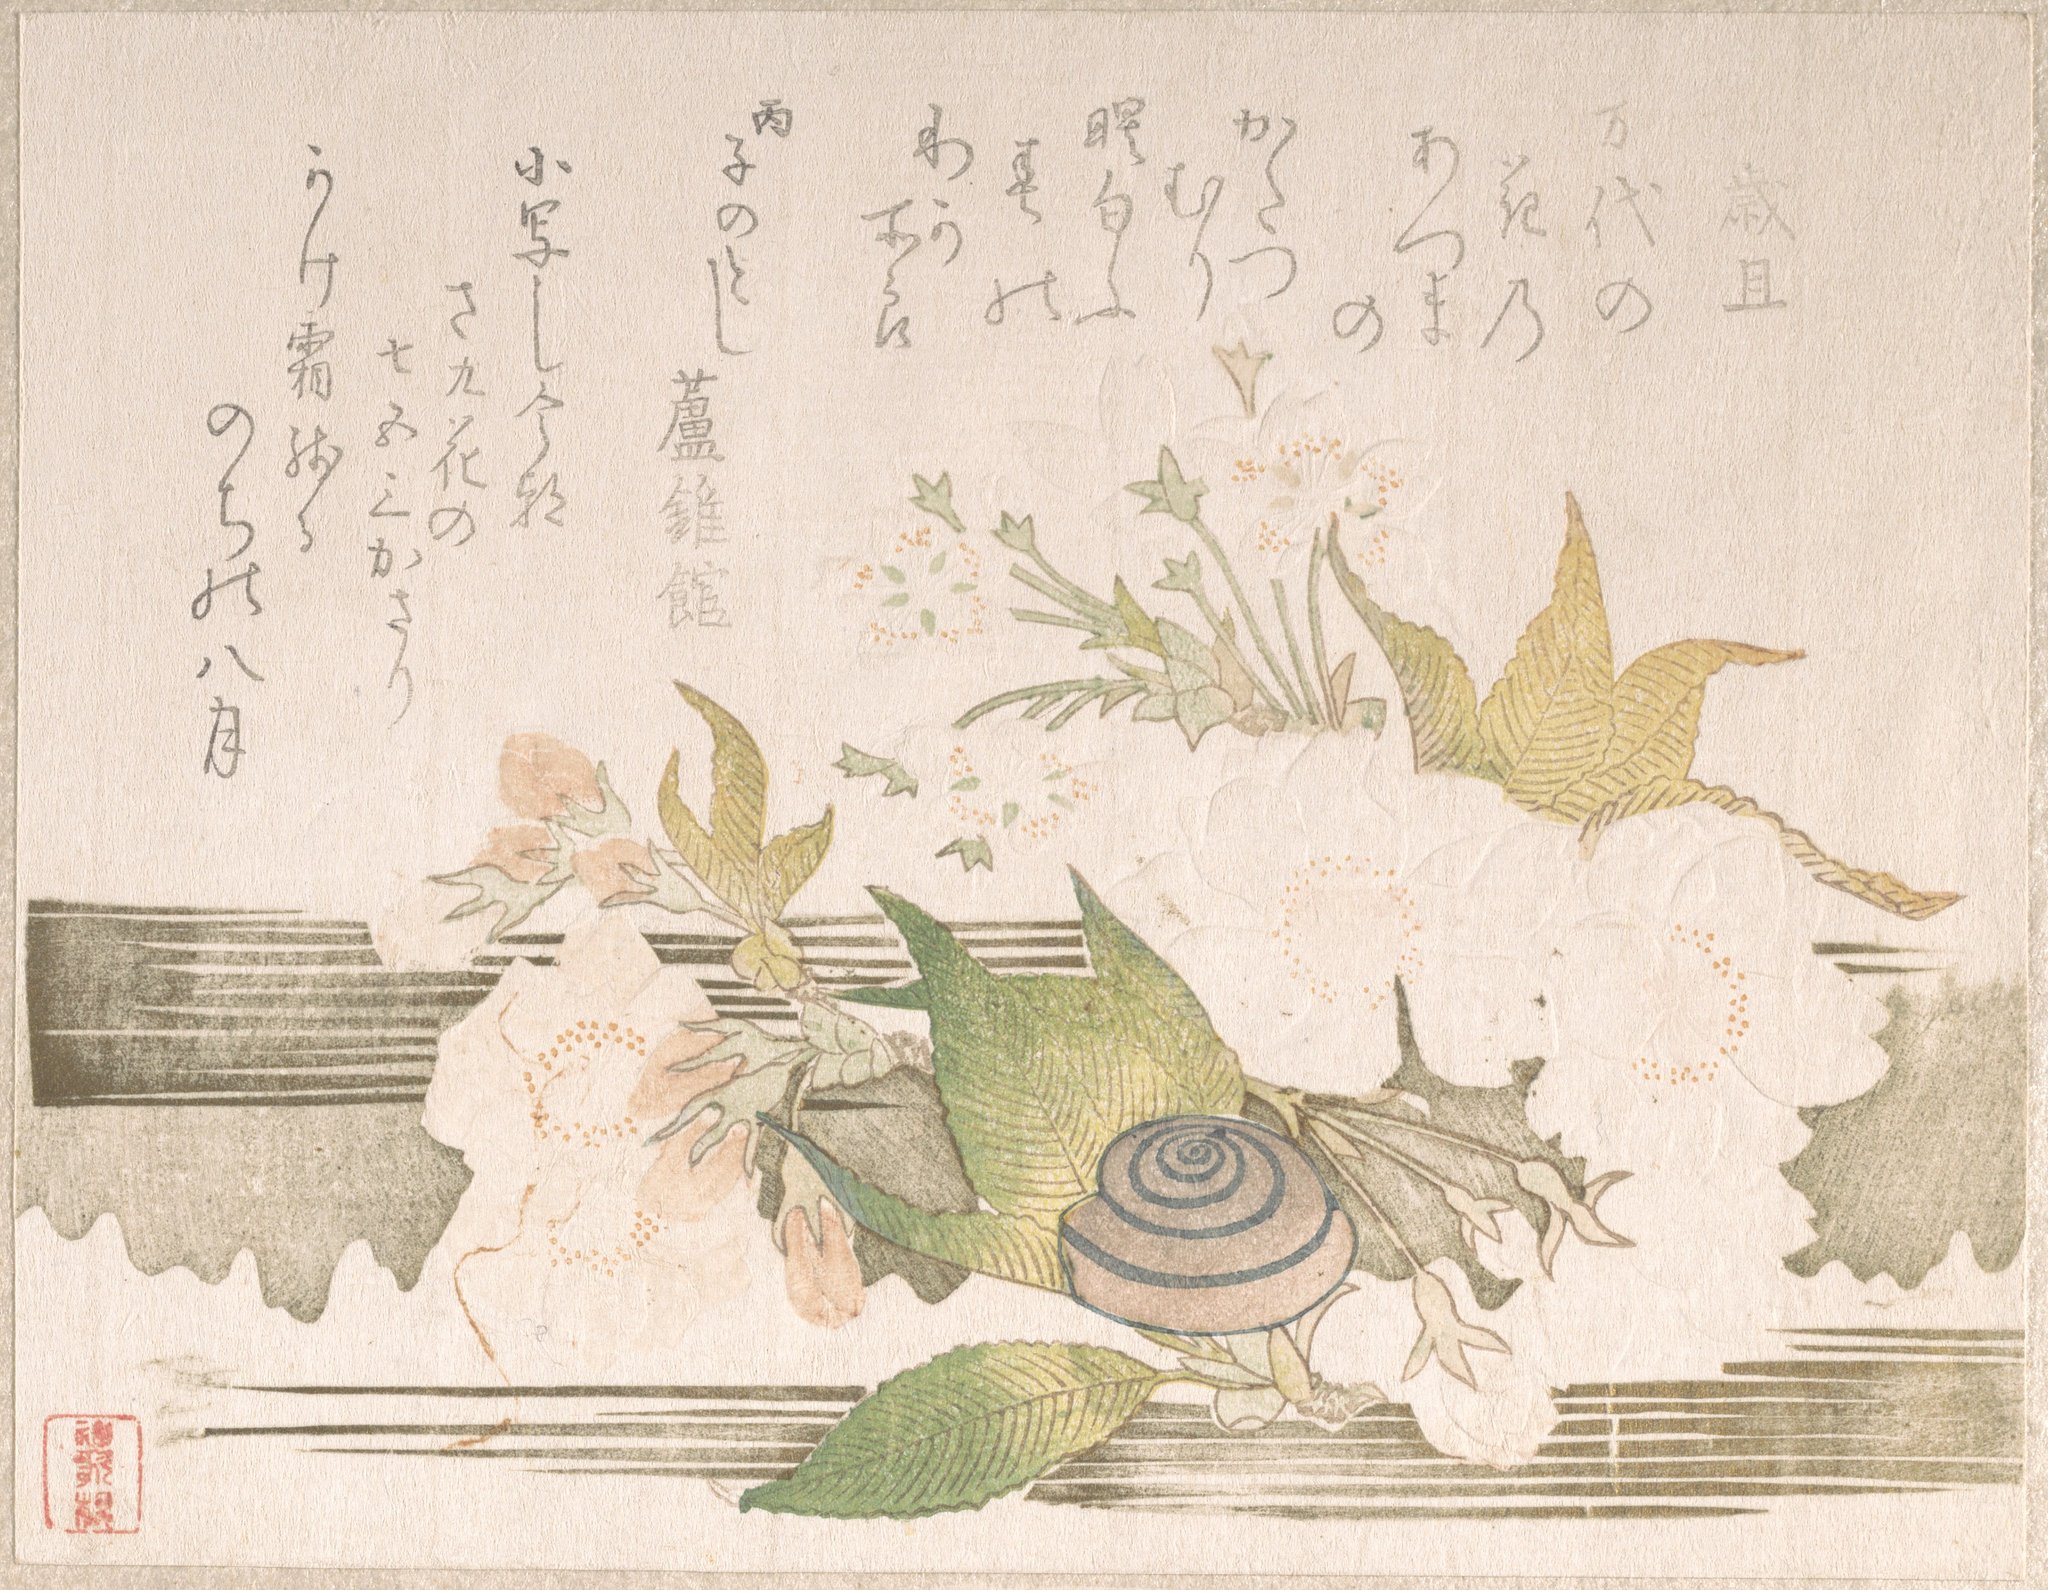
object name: print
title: Cherry Blossoms and a Snail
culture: japanese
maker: unidentified artist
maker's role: artist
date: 1816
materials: ink, paper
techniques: surimono, woodblock print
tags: snails,flowers